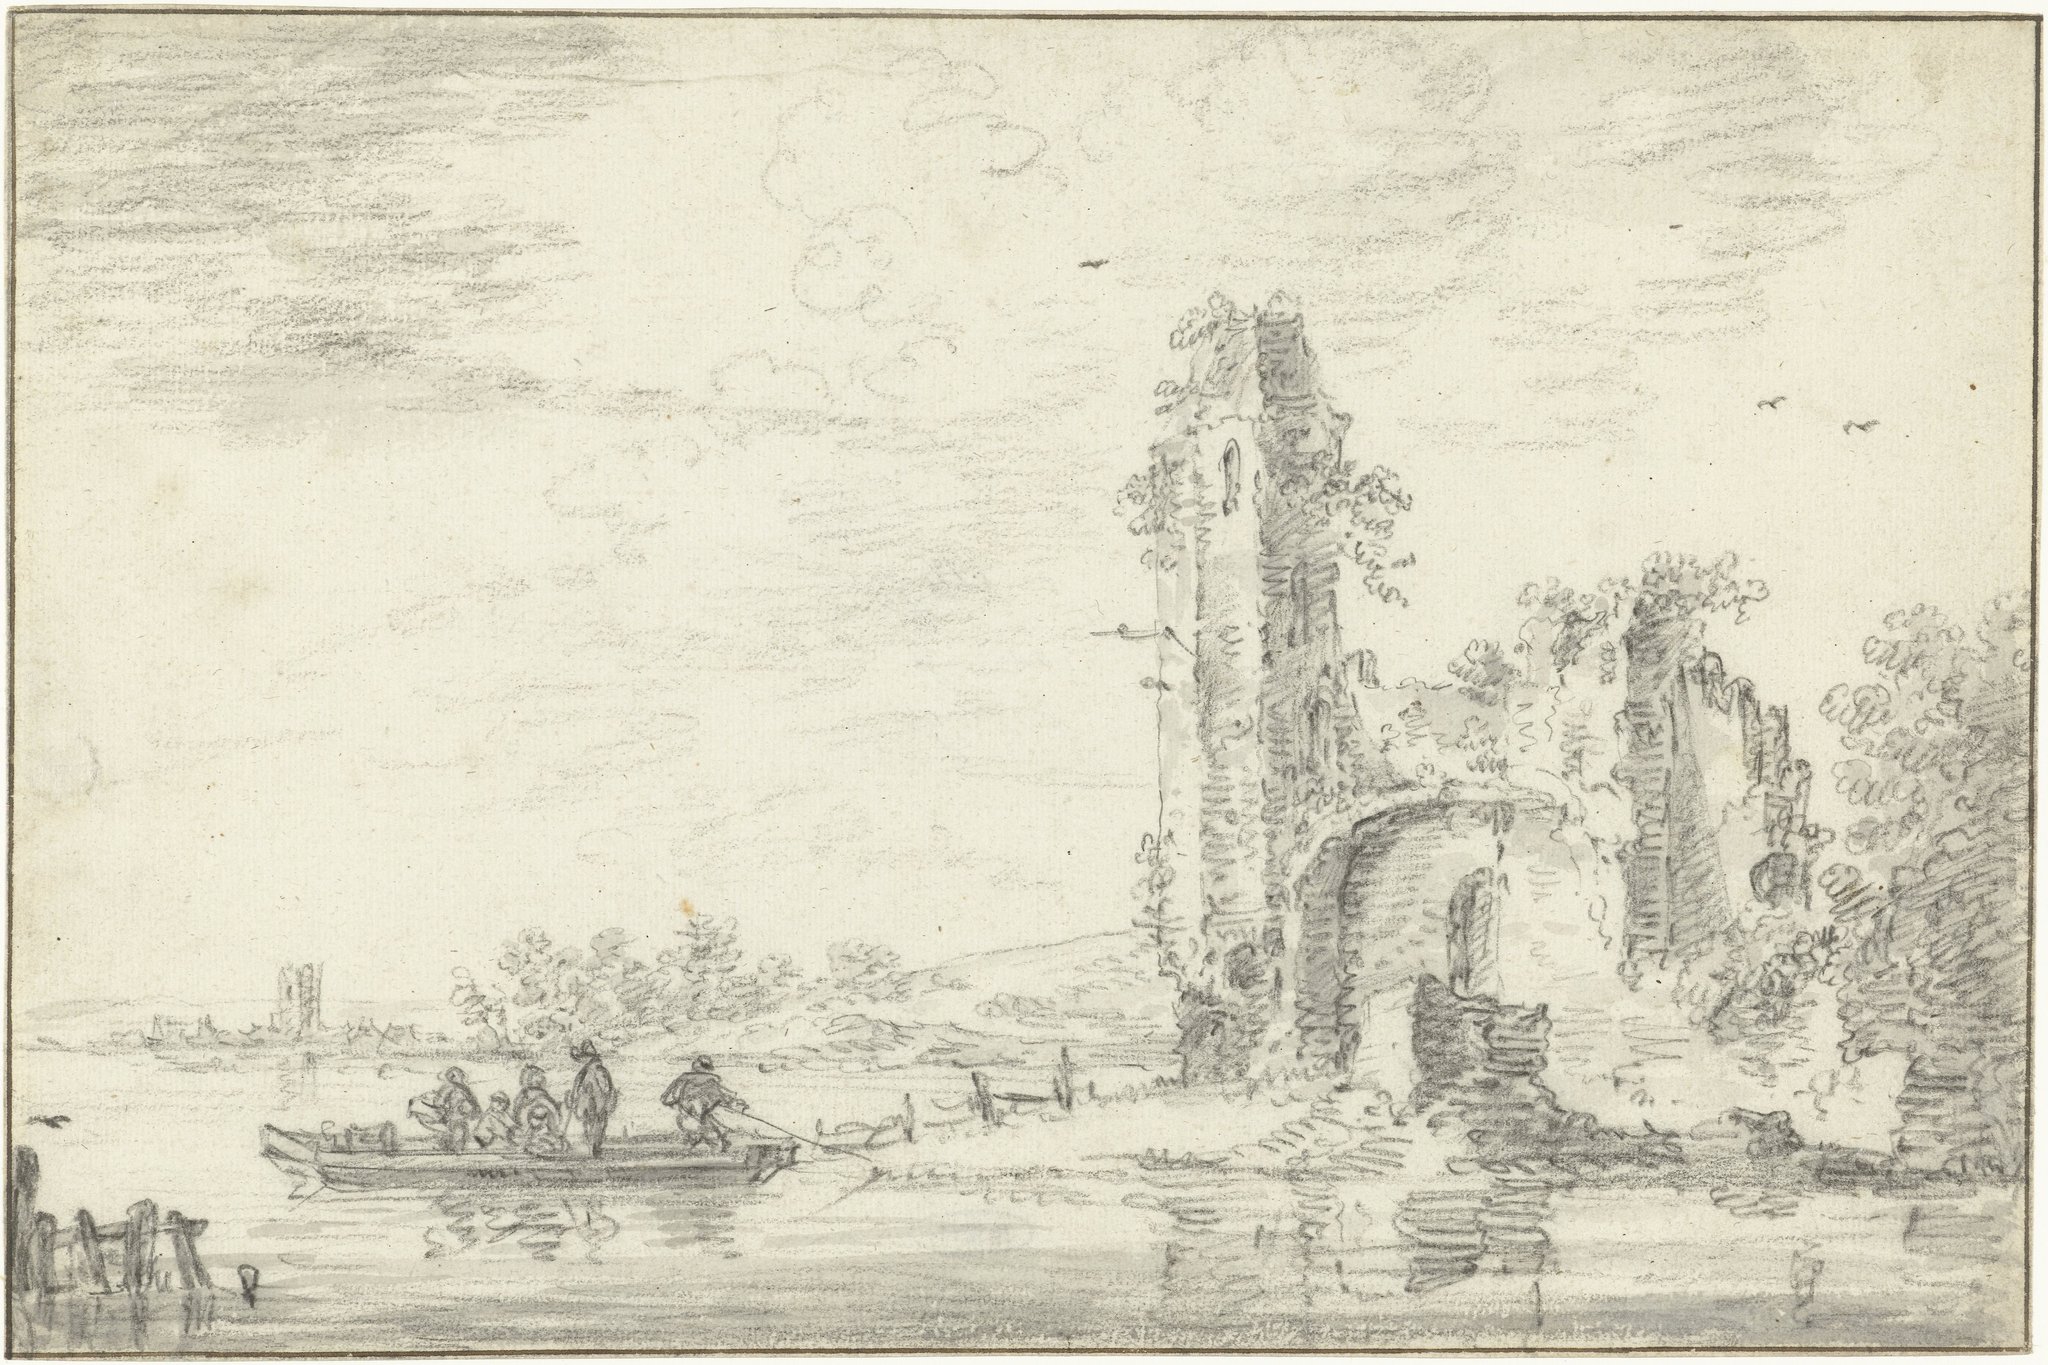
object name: drawing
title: Ruïne van het kasteel Borgvliet(?)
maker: jan van goyen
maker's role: draughtsman, painter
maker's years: 1596-1656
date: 1643-1652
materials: chalk, paper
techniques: brush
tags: landscape with ruins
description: Ruïne van een kasteel aan een rivieroever.